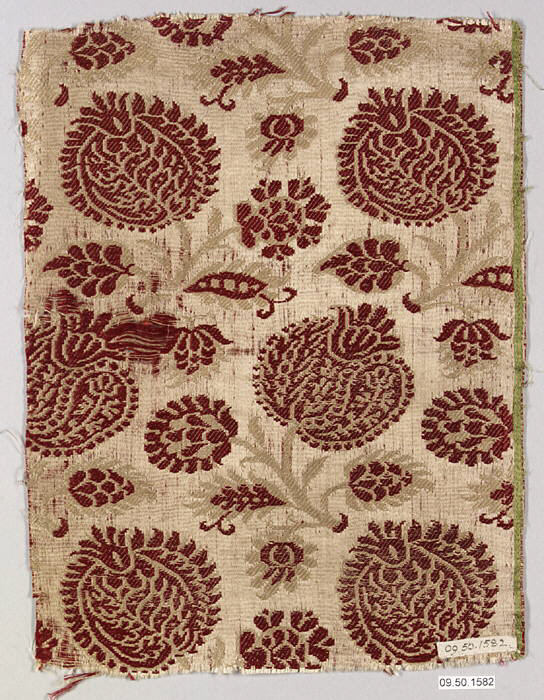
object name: fragment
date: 1640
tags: leaves